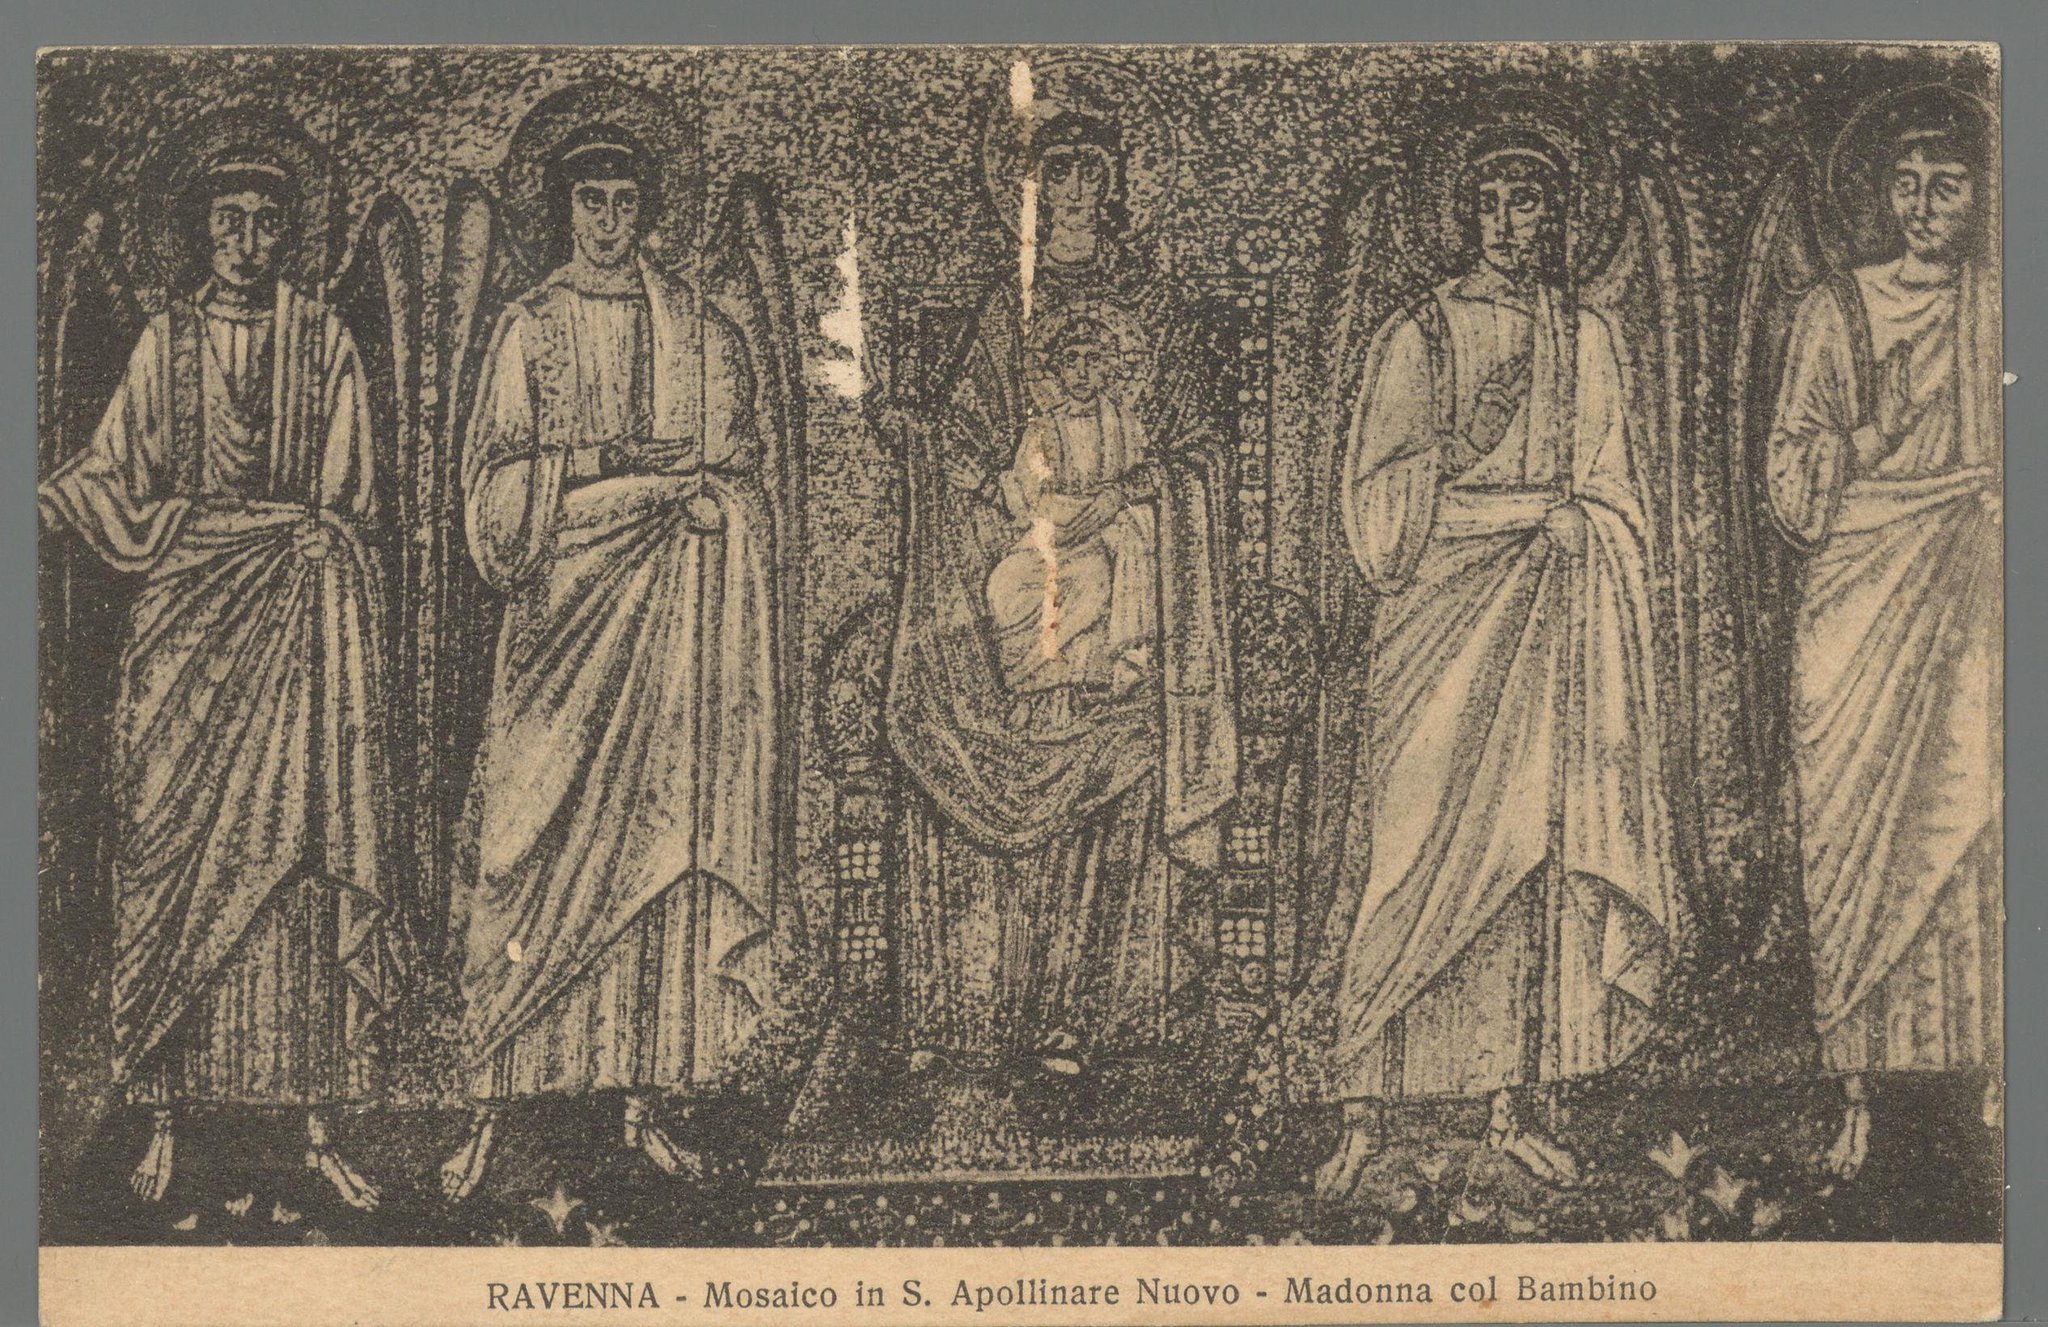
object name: ansichtkaart, prentbriefkaart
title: Ravenna - Mosaico in S. Apollinare Nuovo - Madonna col Bambino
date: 1906-1930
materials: cardboard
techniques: photograph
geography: ravenna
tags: madonna: i.e. mary with the christ-child, interior of church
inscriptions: collector's mark: ‘AFE v S’